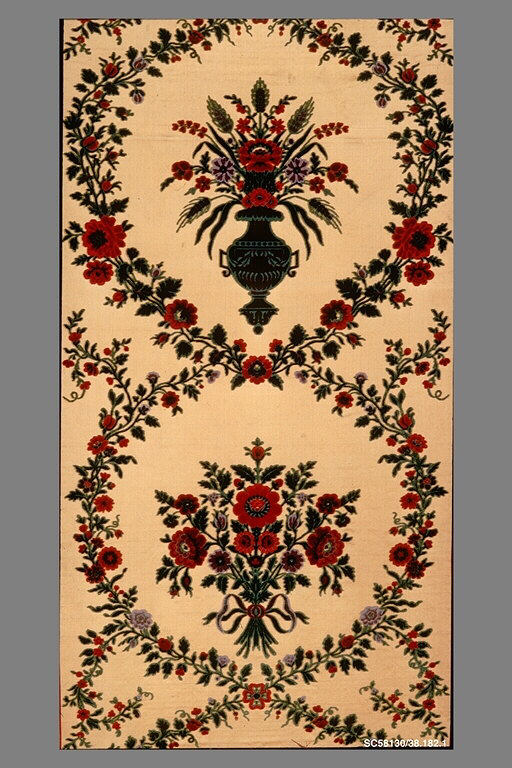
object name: piece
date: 1780-1785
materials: silk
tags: flowers